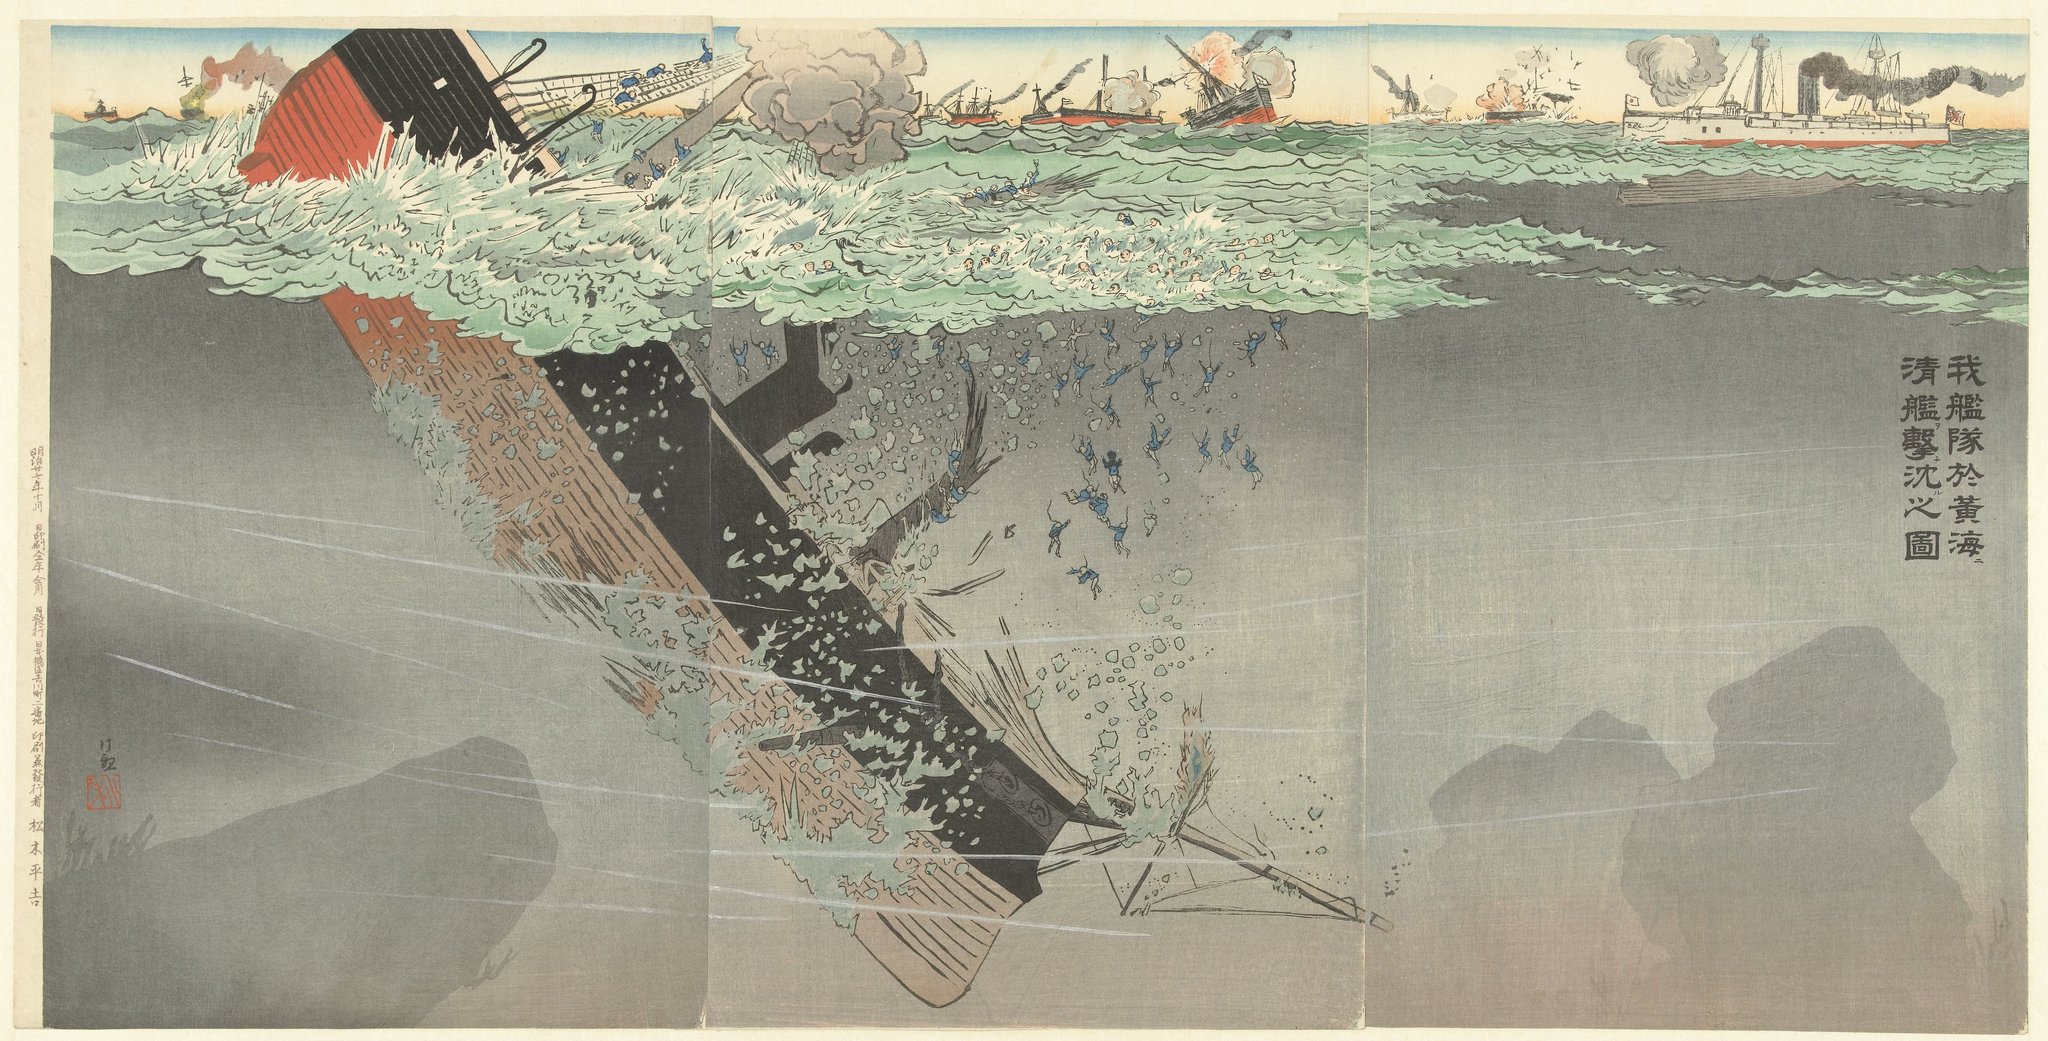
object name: triptych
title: Waga kantai o kokai ni shinkan o uchi shizumeru zu.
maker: kobayashi kiyochika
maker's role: print maker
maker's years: 1847-1915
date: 1810-1894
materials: paper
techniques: woodcut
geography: tokyo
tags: war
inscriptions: collector's mark: Lugt 2760, collector's mark: Lugt 2228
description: Gezicht zowel boven als onder water op een zinkend Chinees oorlogsschip met verdrinkende opvarenden. Boven water op elkaar schietende oorlogsschepen.